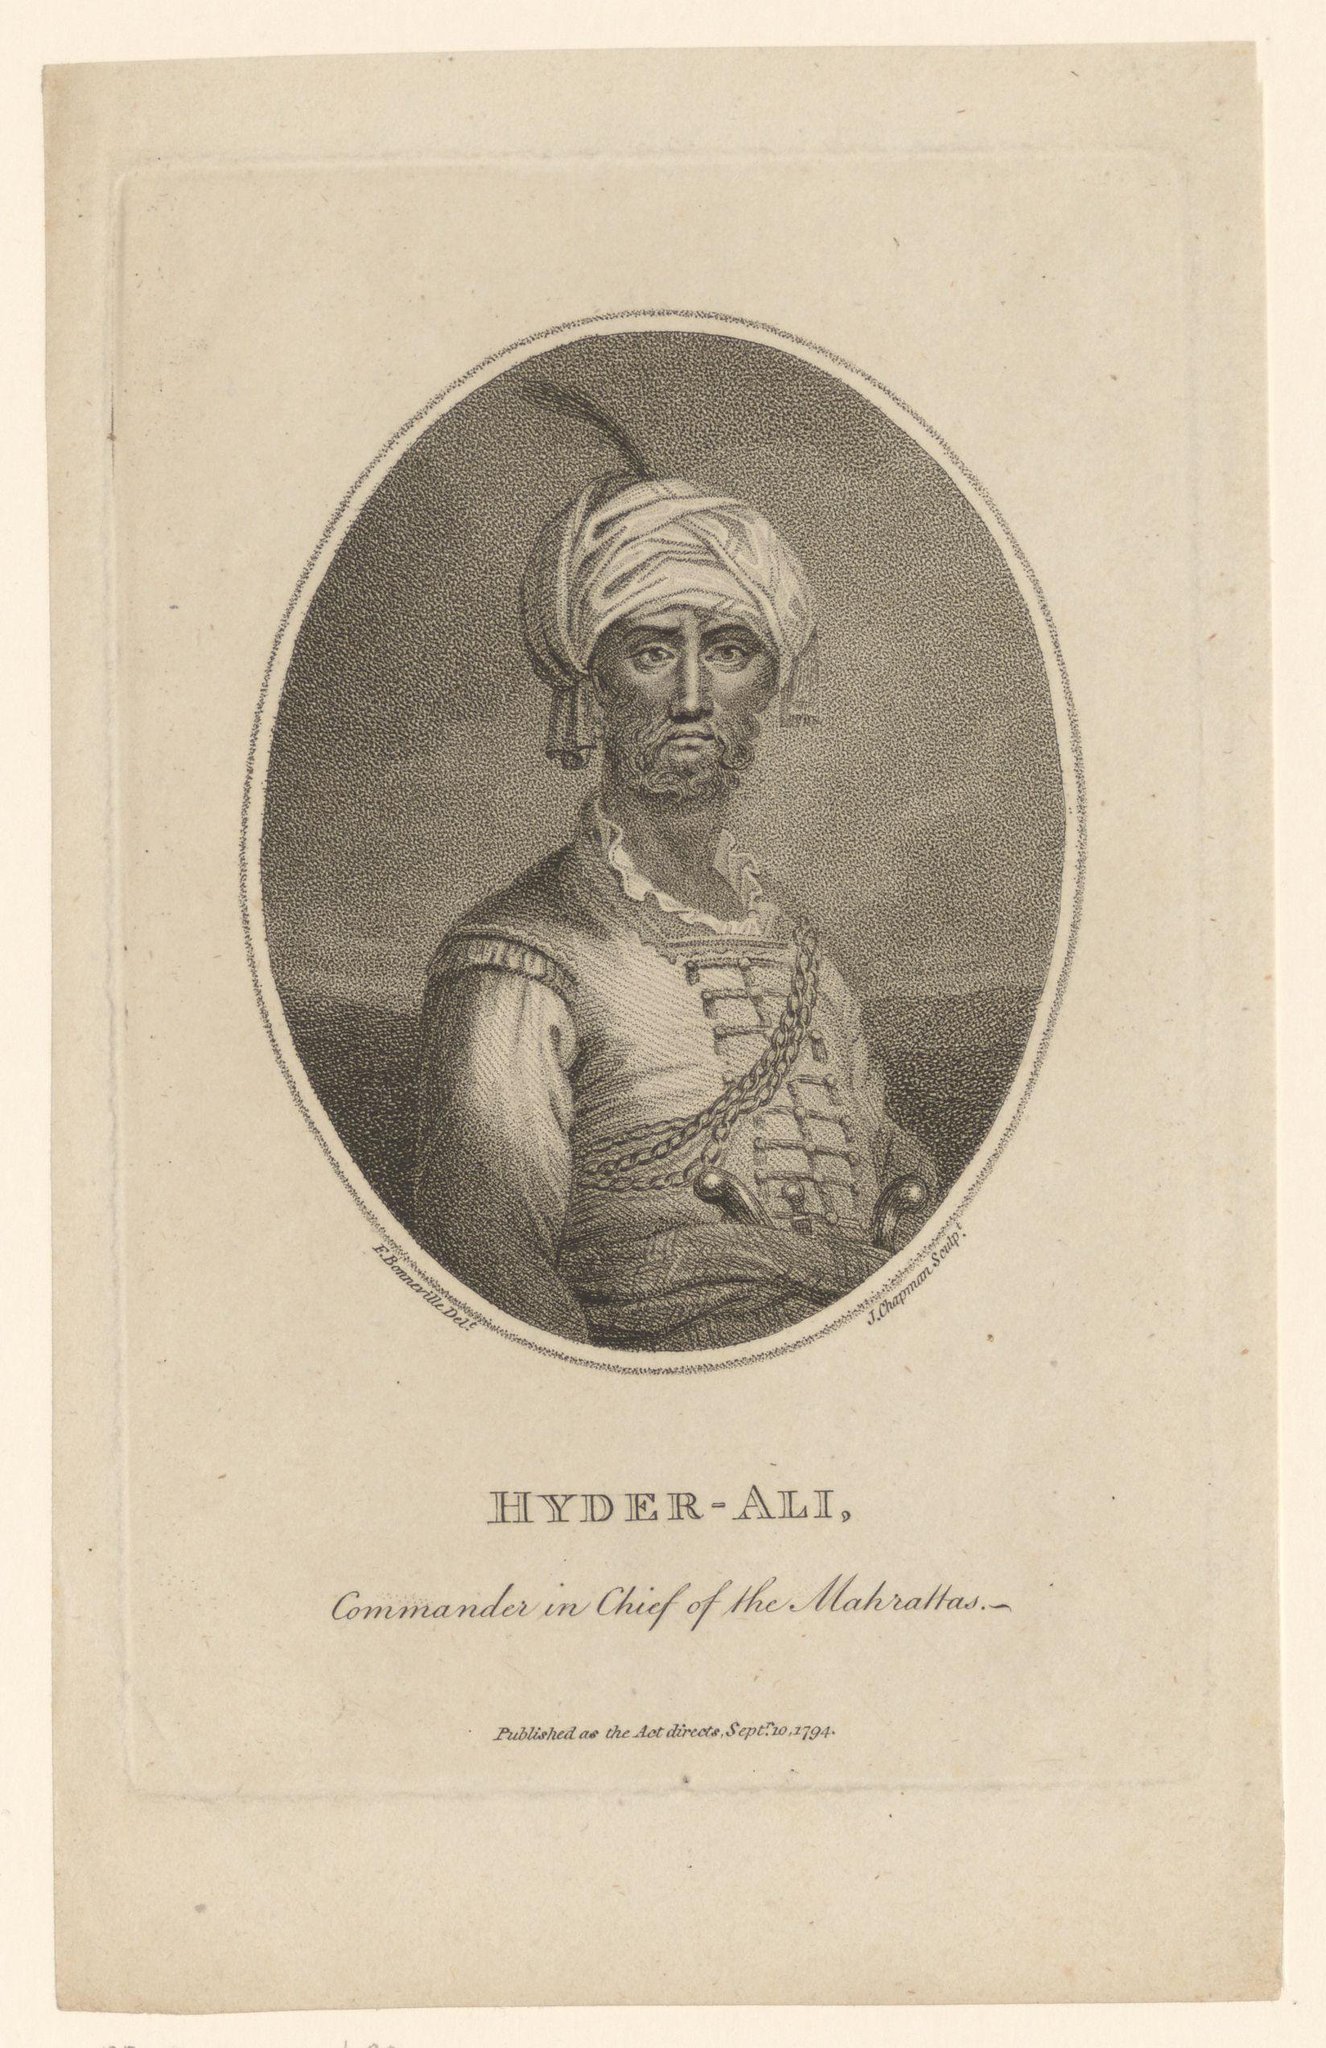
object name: print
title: Hyder-Ali Commander in chief of the Mahratta's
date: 1794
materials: paper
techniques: stippling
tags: politician, commander-in-chief, general, marshal, historical persons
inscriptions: collector's mark: Lugt 2228